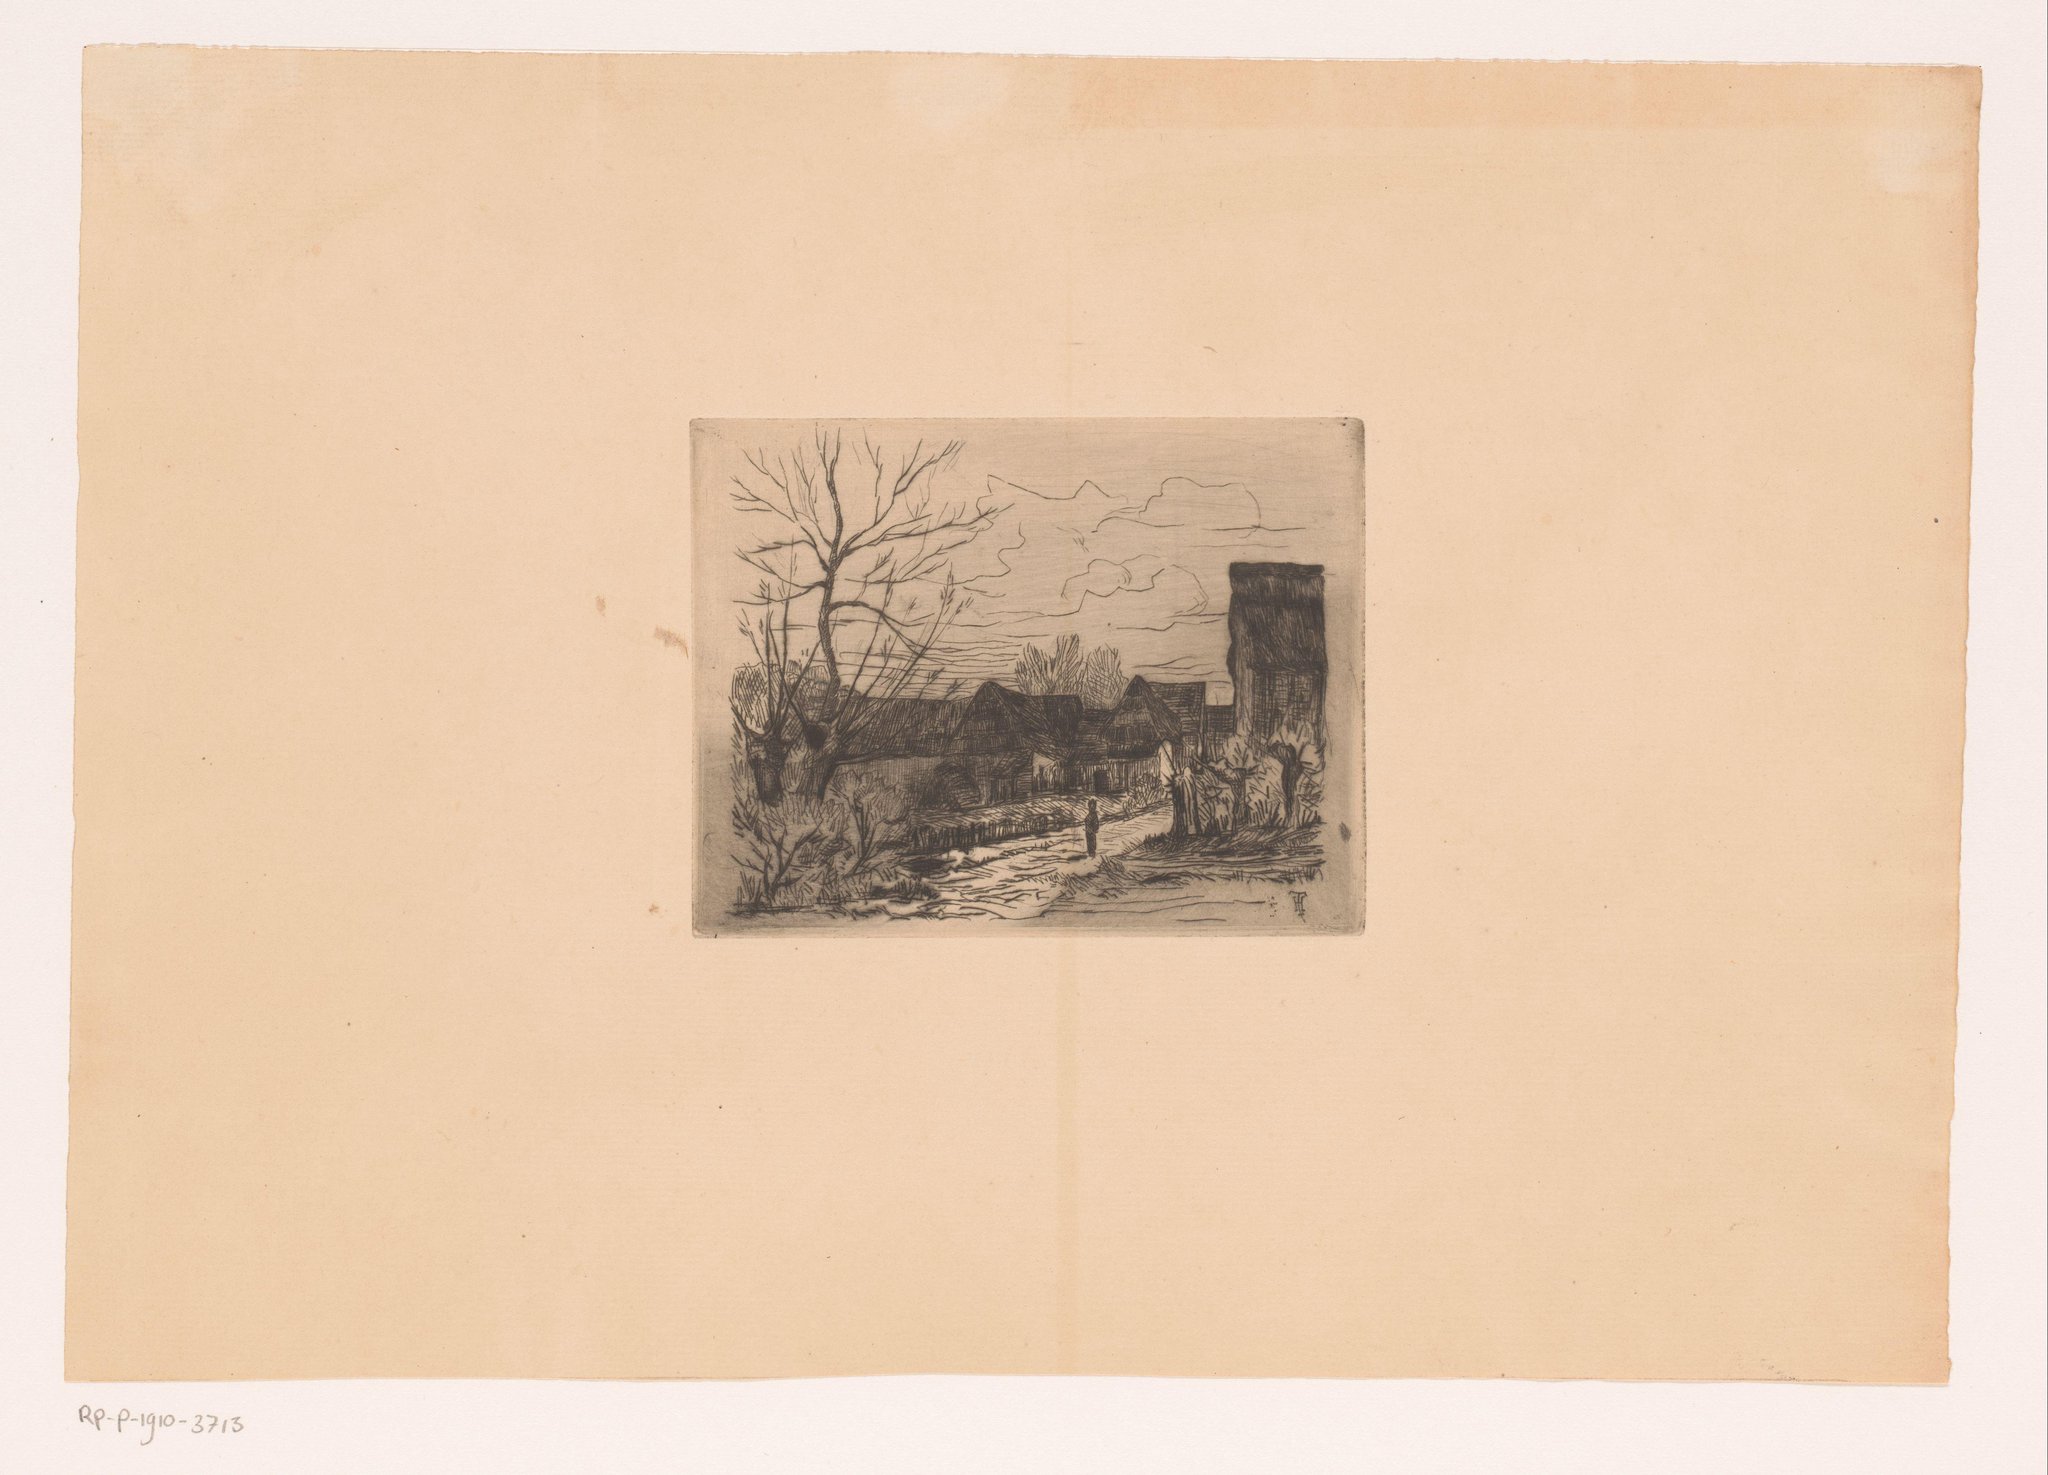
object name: print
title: Dorpsgezicht met figuur op een weg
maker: theodoor hannon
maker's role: print maker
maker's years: 1851-1917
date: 1861-1910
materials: paper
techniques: etching, intaglio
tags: village, road, path, postures of the human figure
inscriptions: collector's mark: Lugt 2228